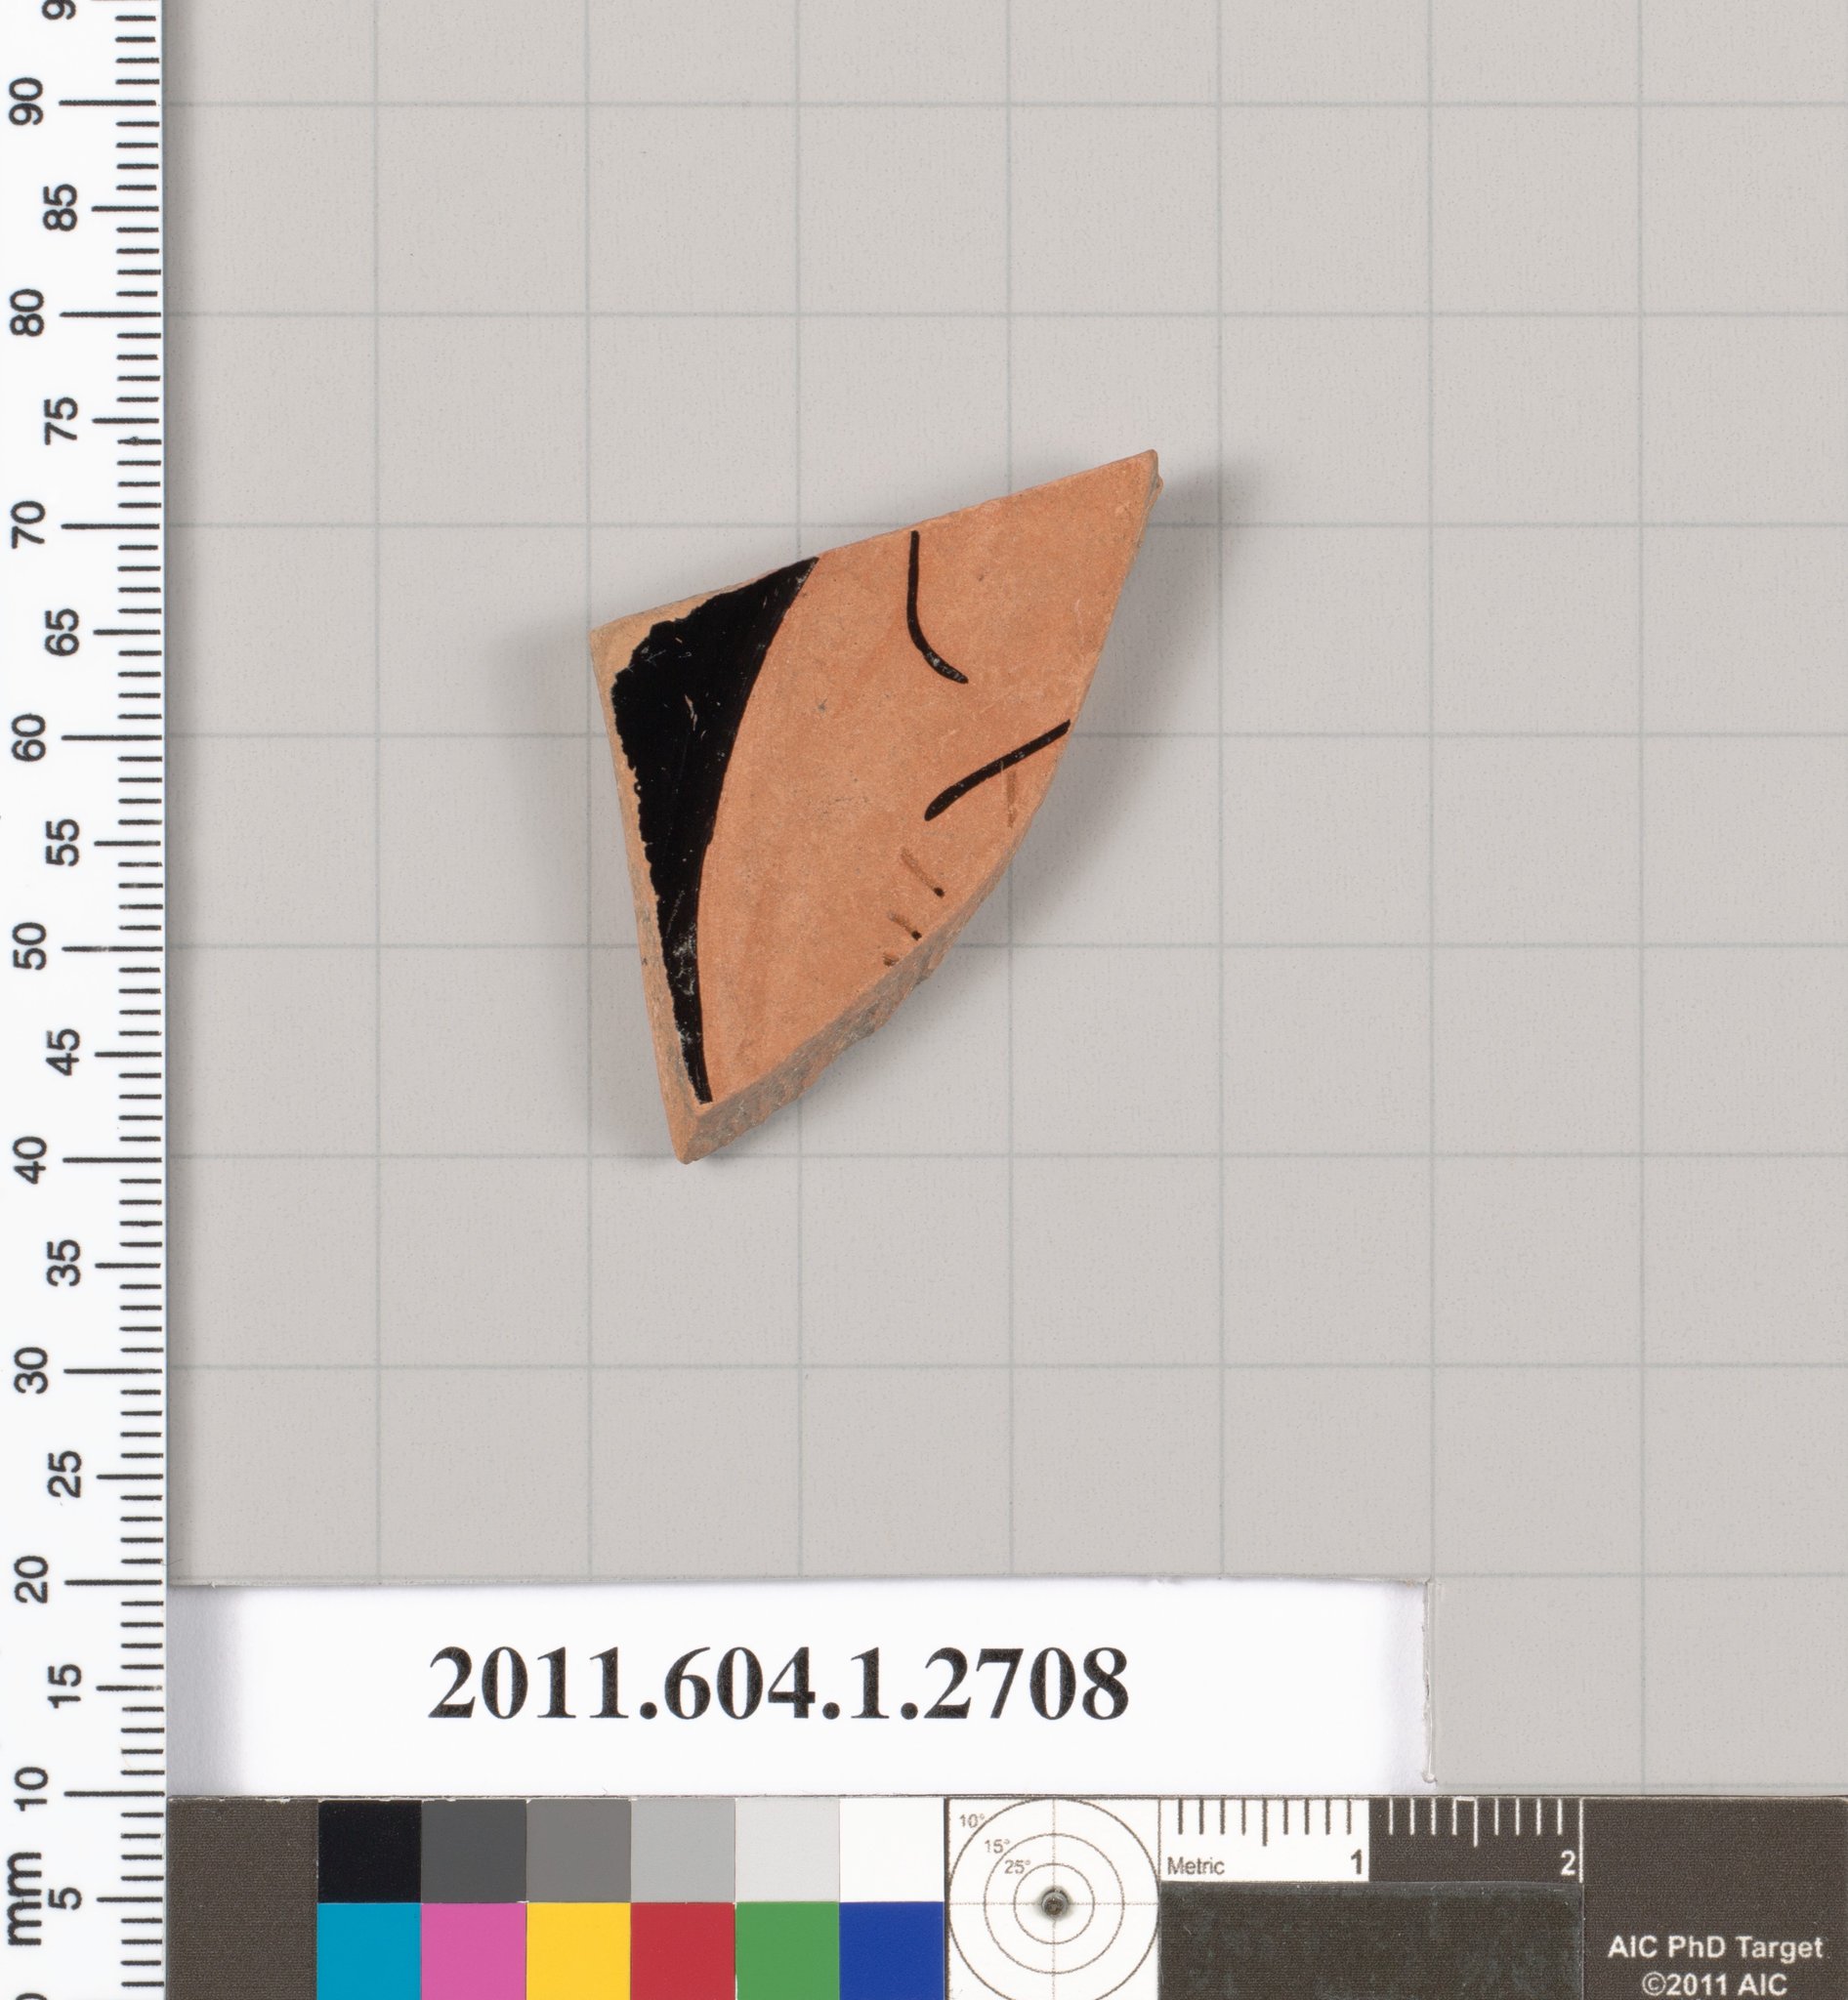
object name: kylix fragment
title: Terracotta fragment of a kylix (drinking cup)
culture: greek, attic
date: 500-490 BCE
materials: terracotta